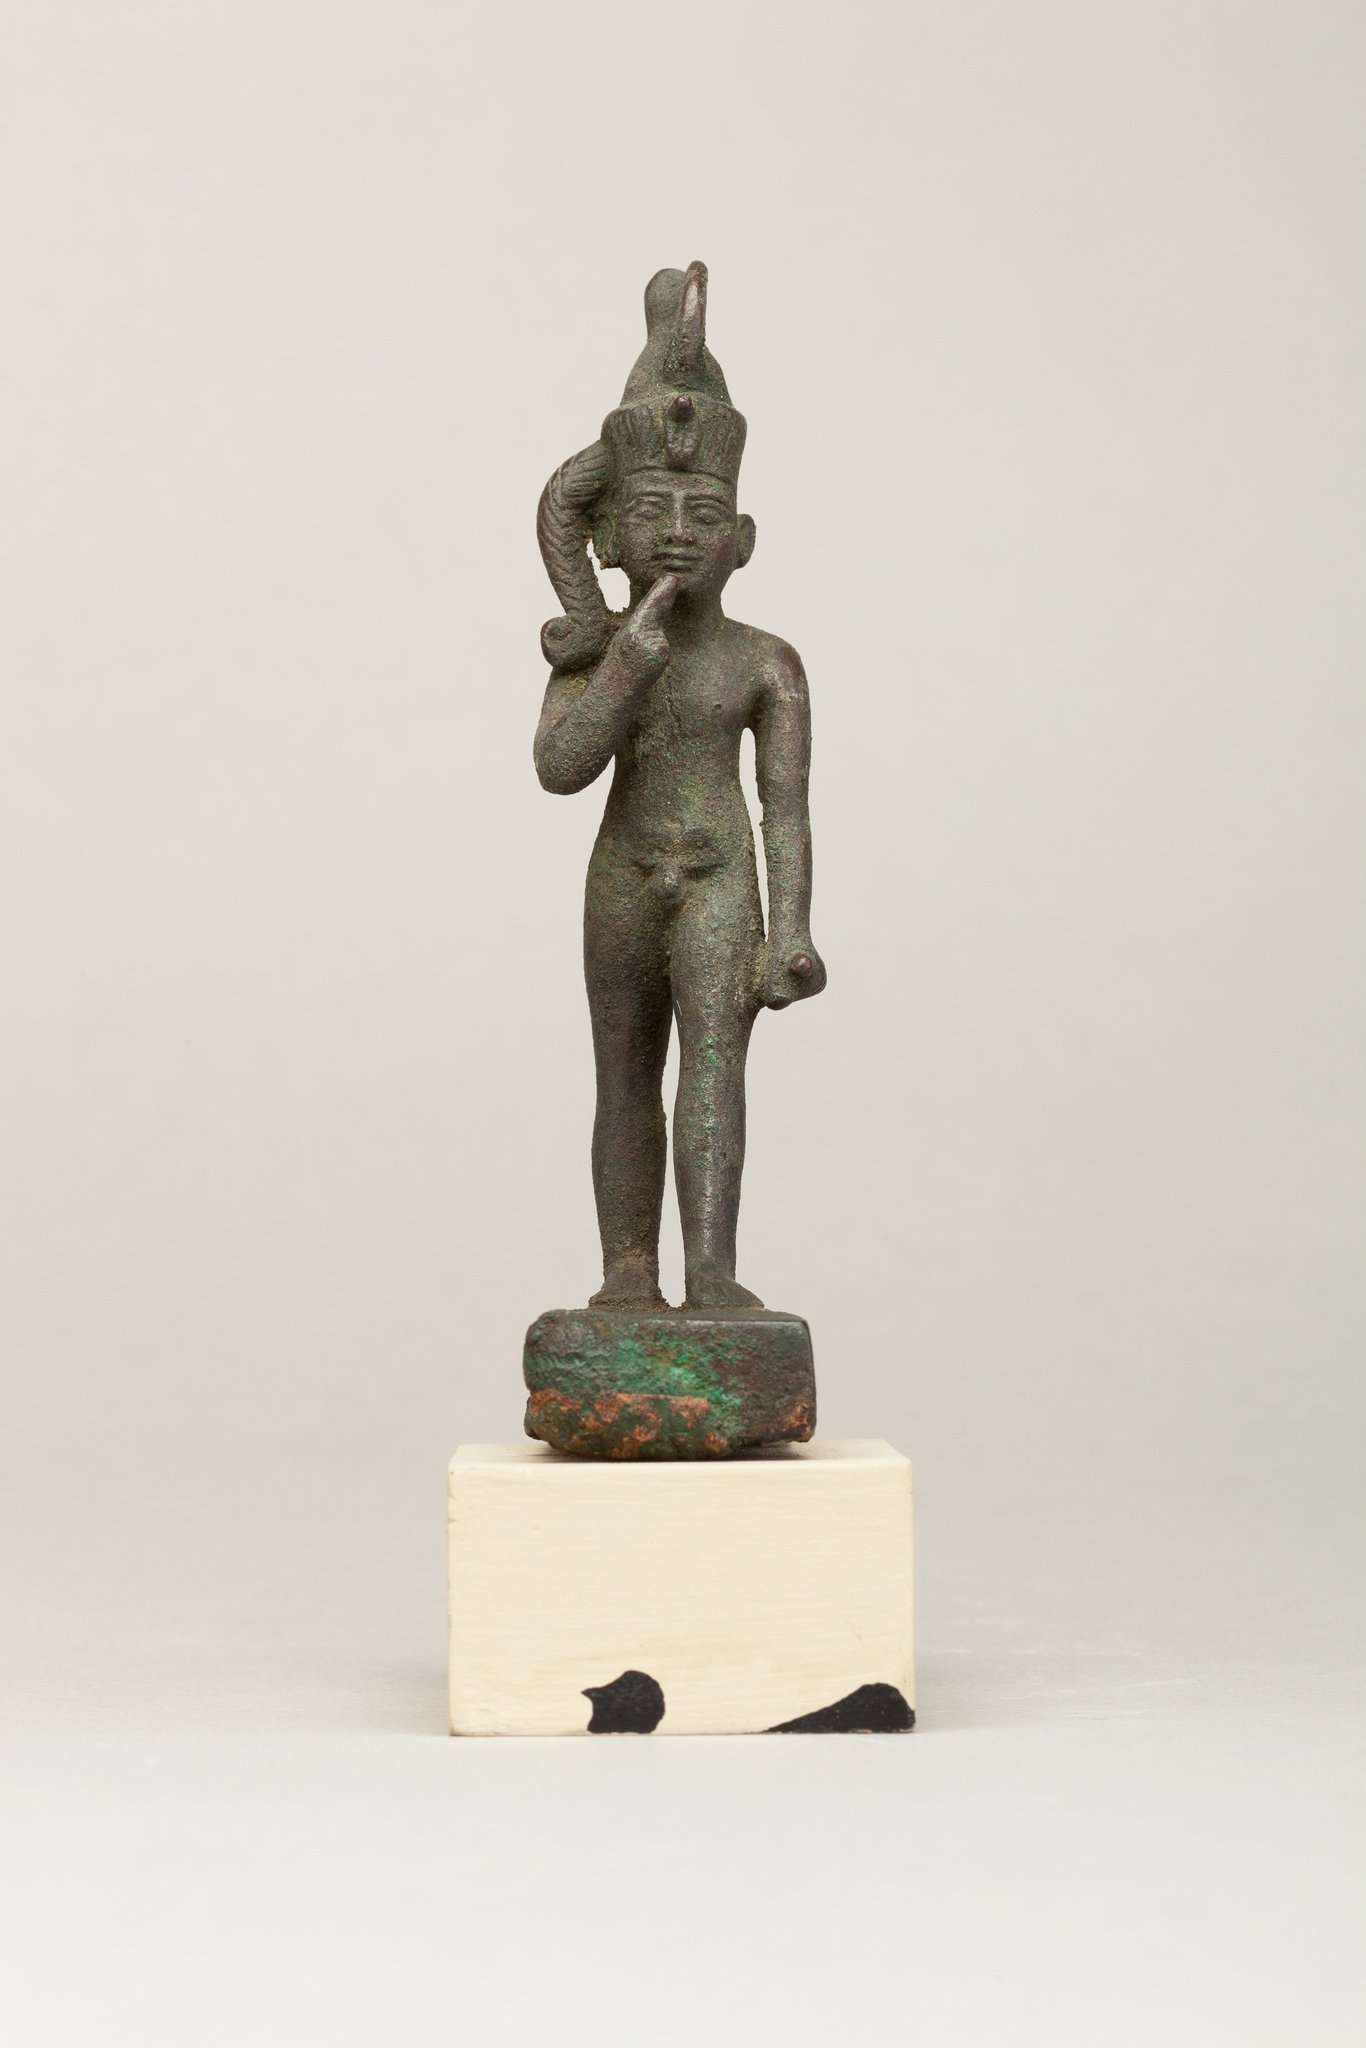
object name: figurine, harpokrates, double crown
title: Harpokrates in double crown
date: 664-630 BCE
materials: metal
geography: egypt